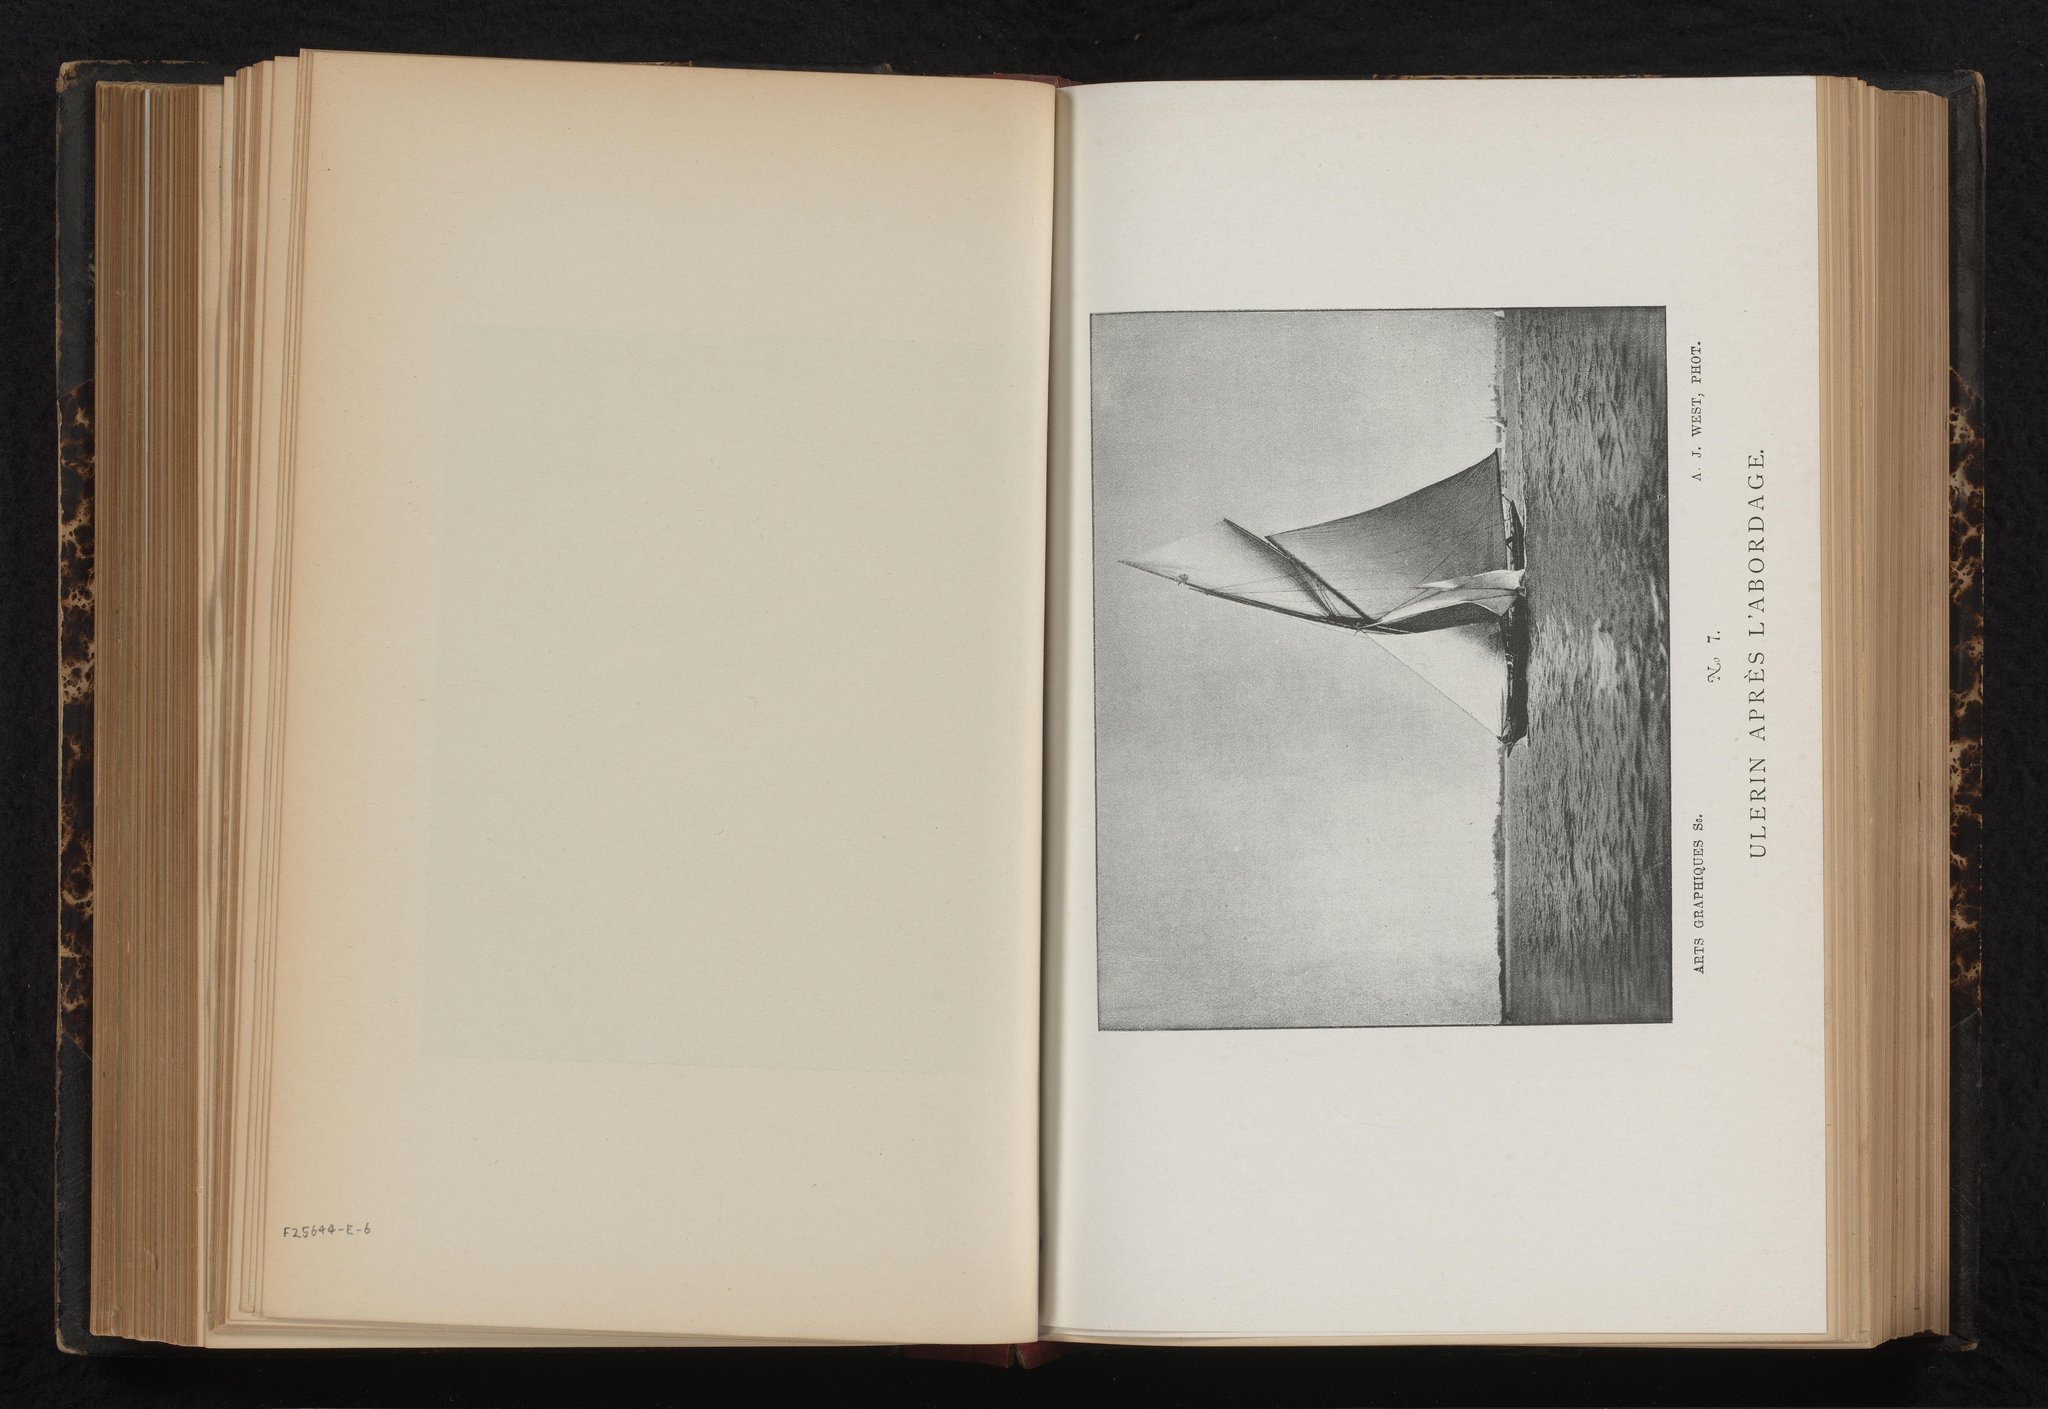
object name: page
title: Ulerin après l'abordage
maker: a.j. west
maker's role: fotograaf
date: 1881-1886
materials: paper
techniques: photograph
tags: sailing-ship, sailing-boat